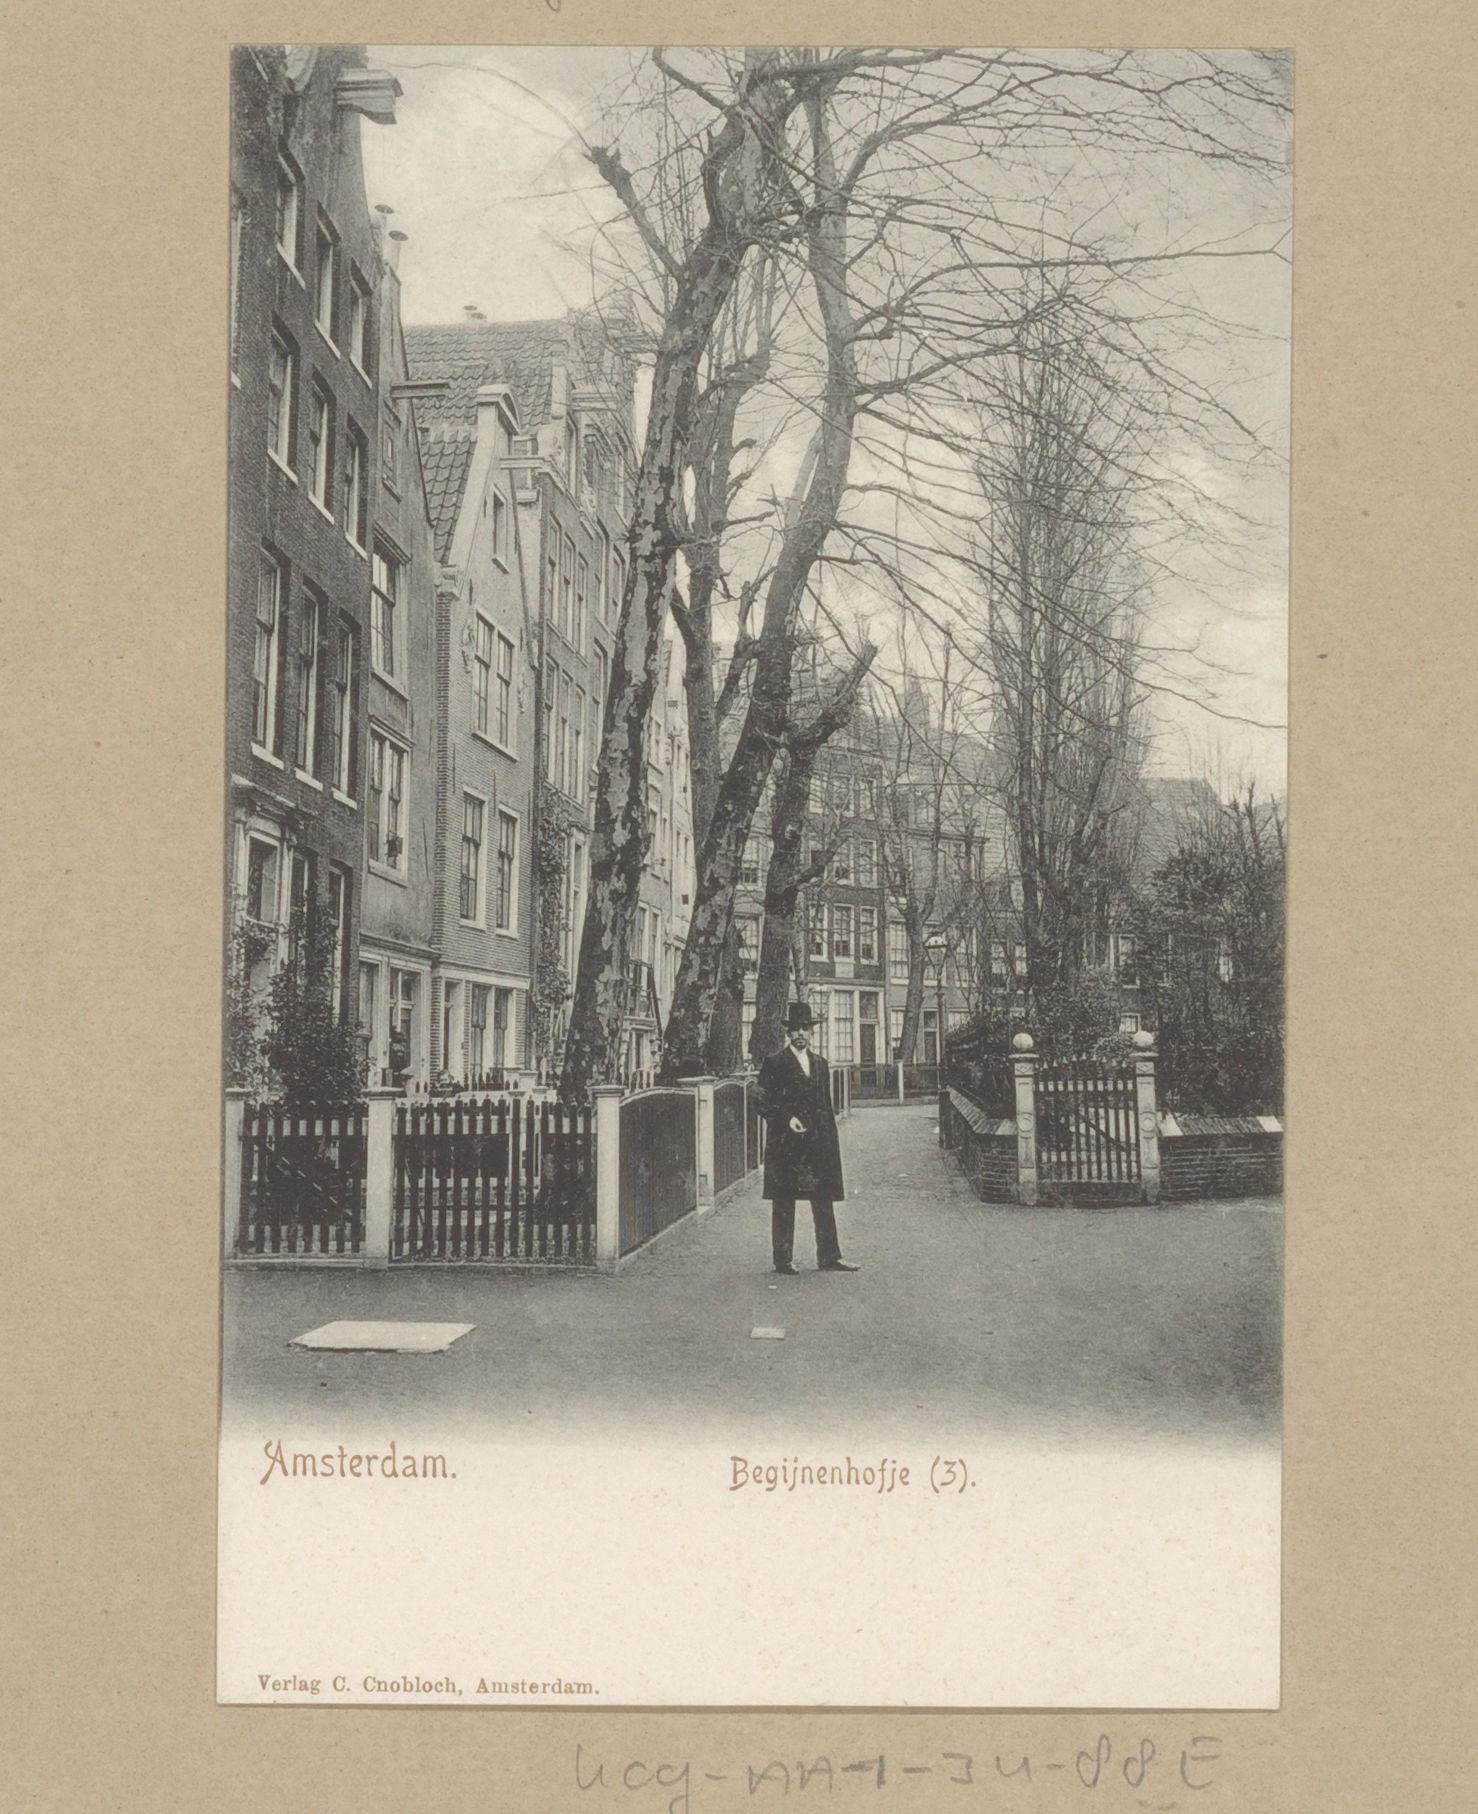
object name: ansichtkaart, prentbriefkaart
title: Gezicht op het Begijnhof te Amsterdam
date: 1892-1905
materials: paper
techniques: photograph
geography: netherlands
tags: street (+ city(-scape) with figures, staffage)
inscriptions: collector's mark: Lugt 1641b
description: Onderwerpsrubriek binnen de Atlas Amsterdam: Kerkwezen: R.K. Gemeenten: Begijnhof t/m Petrus en Paulus.